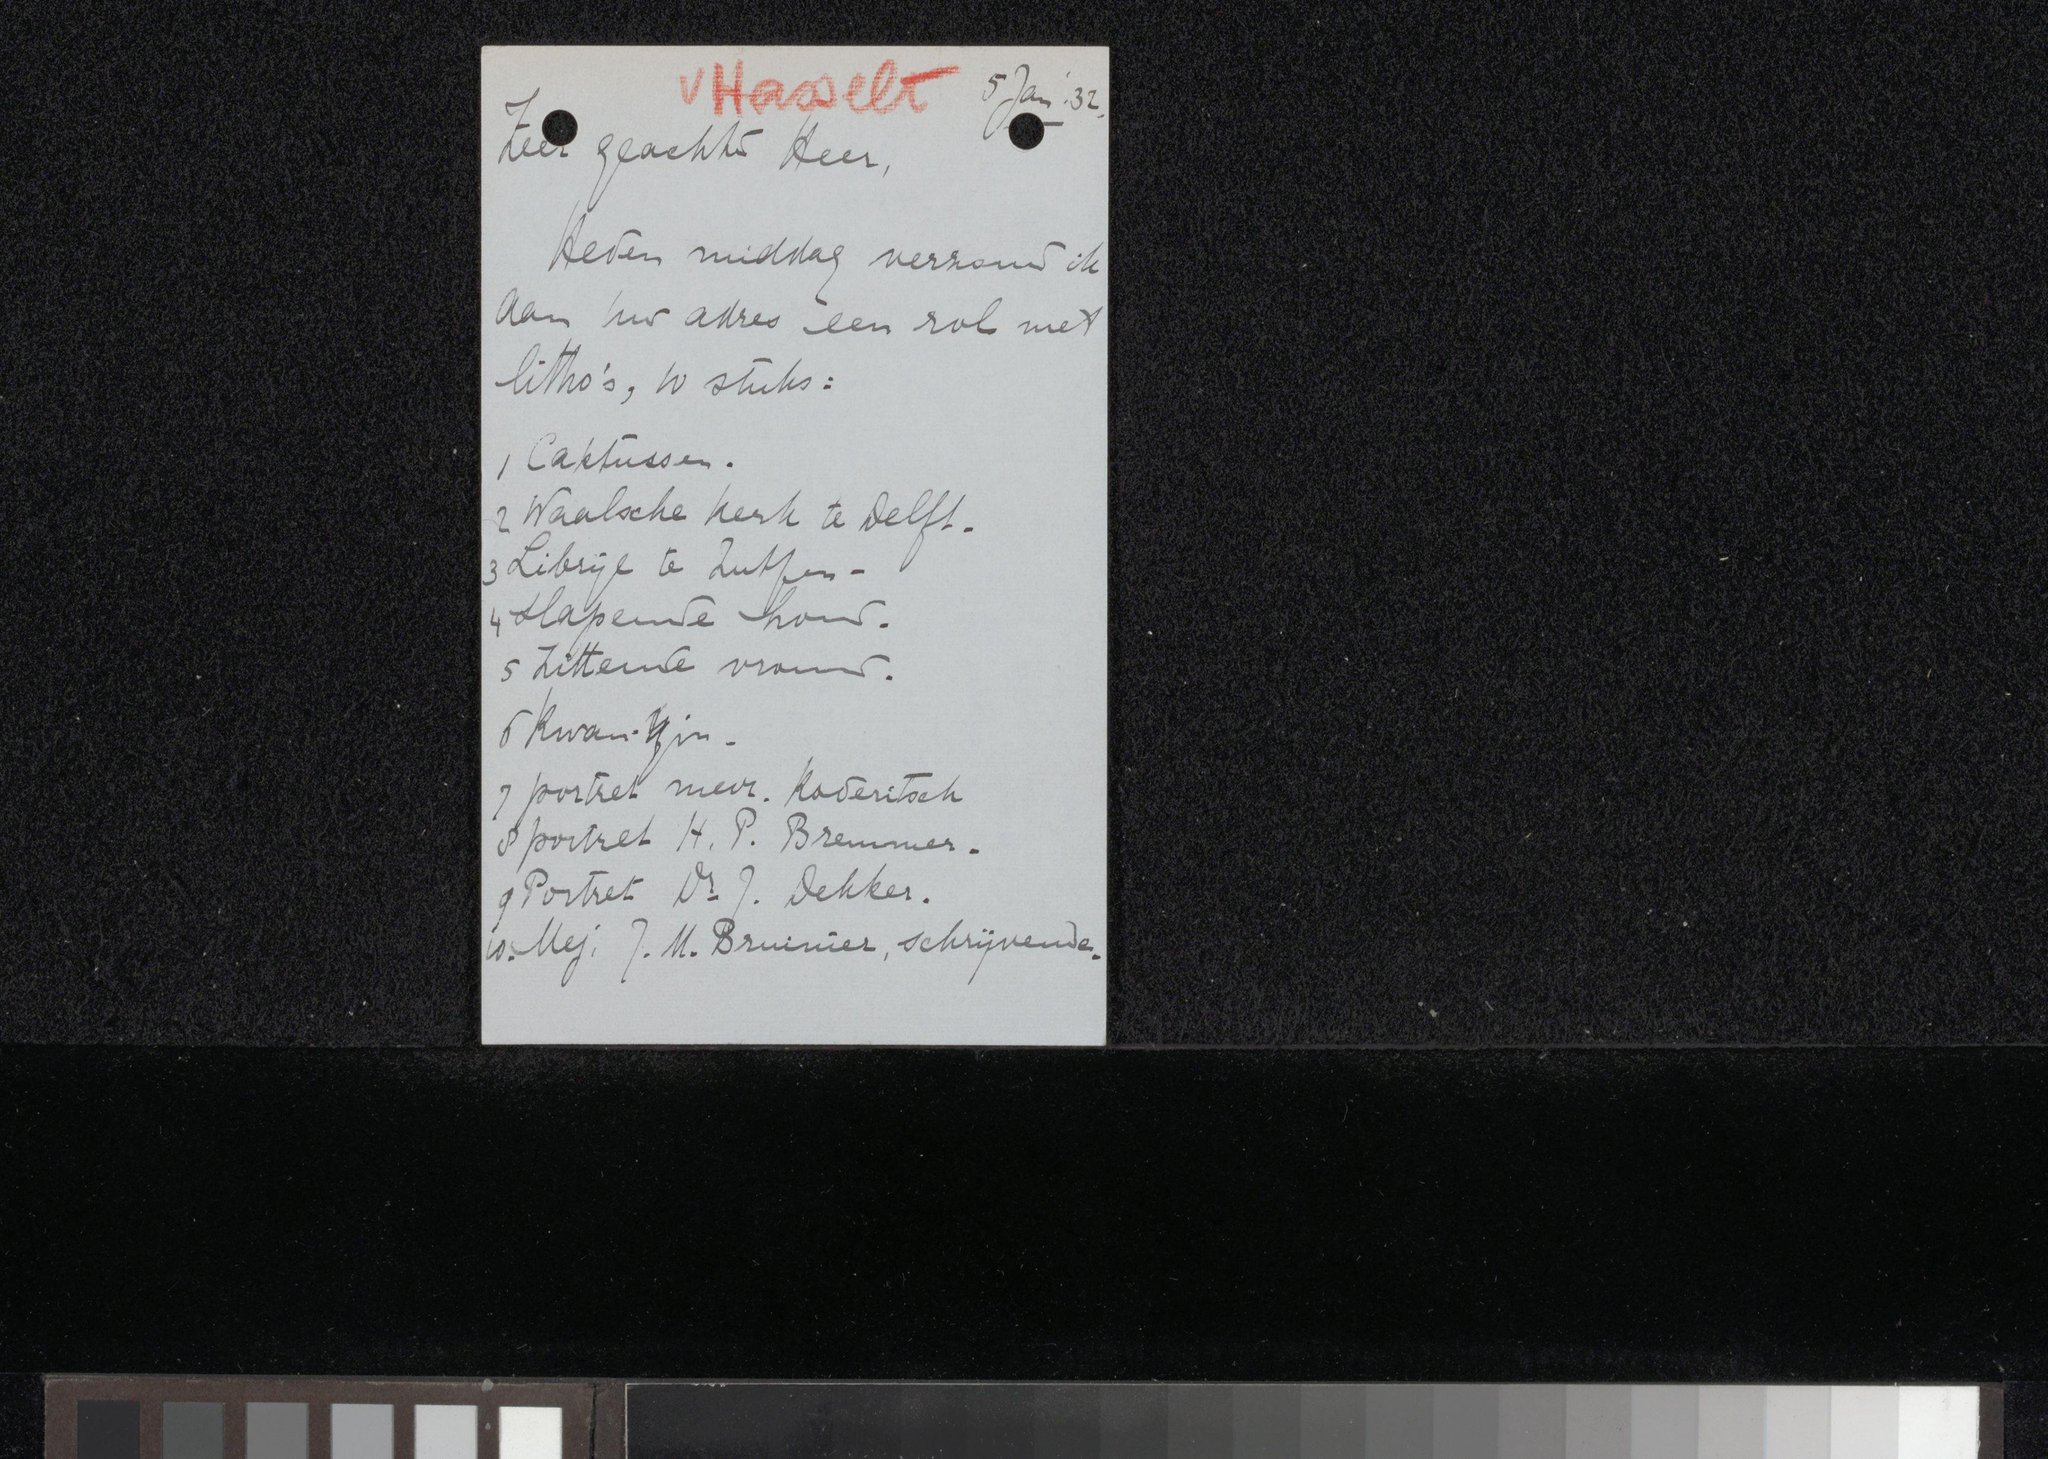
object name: letter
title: Brief aan jonkheer Hendrik Teding van Berkhout (1879-1969)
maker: bertha van hasselt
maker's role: print maker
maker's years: 1878-1932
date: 1932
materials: cardboard, ink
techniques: pen, writing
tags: leiden, hendricus petrus bremmer, haarlem, amsterdam, jonkheer hendrik teding van berkhout (1879-1969), the graphic arts, historical persons (portraits and scenes from the life), money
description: De prenten onder gerelateerd object worden genoemd in de brief.